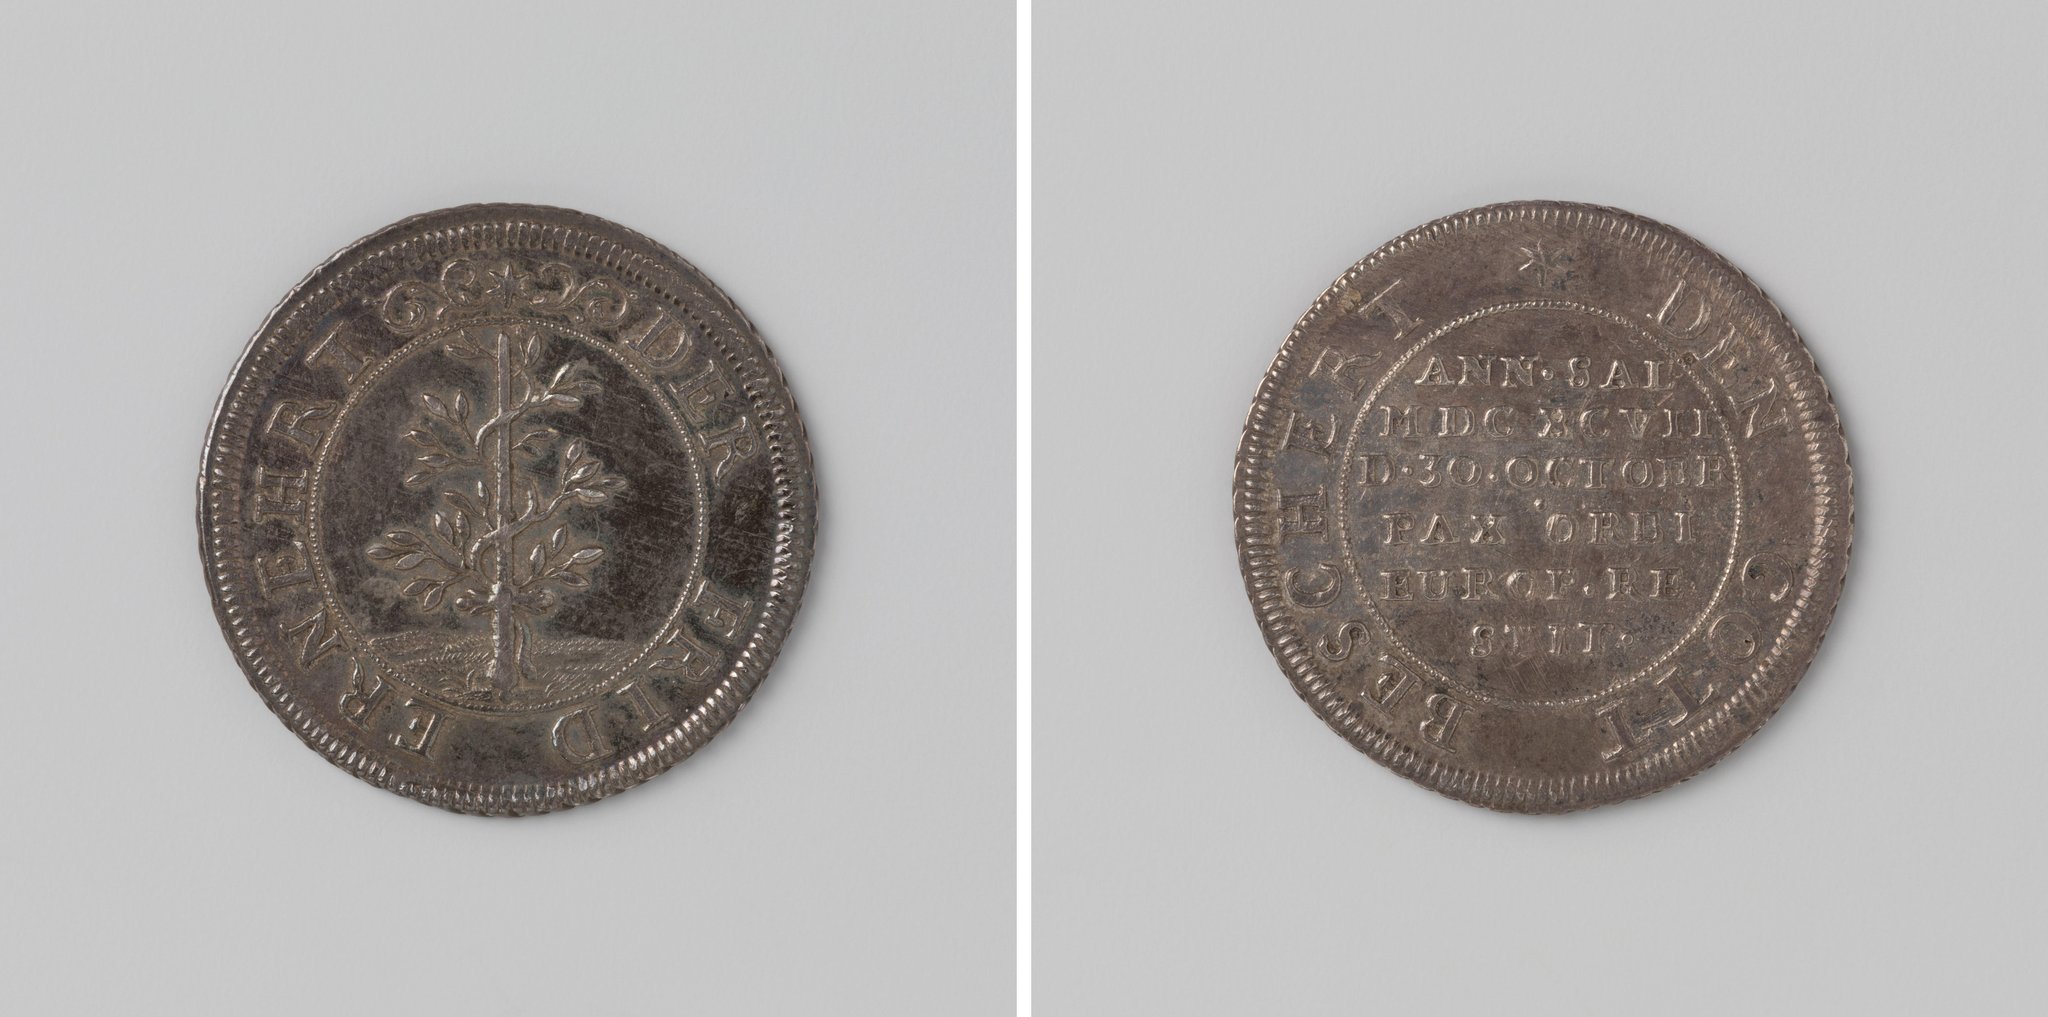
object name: jeton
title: Vrede van Rijswijk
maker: Anonymous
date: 1697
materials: silver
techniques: striking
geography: germany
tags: rijswijk, vrede van rijswijk (1697)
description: Zilveren penning. Voorzijde: rechtop staand zwaard omvlochten met olijftak binnen omschrift. Keerzijde: opschrift binnen omschrift